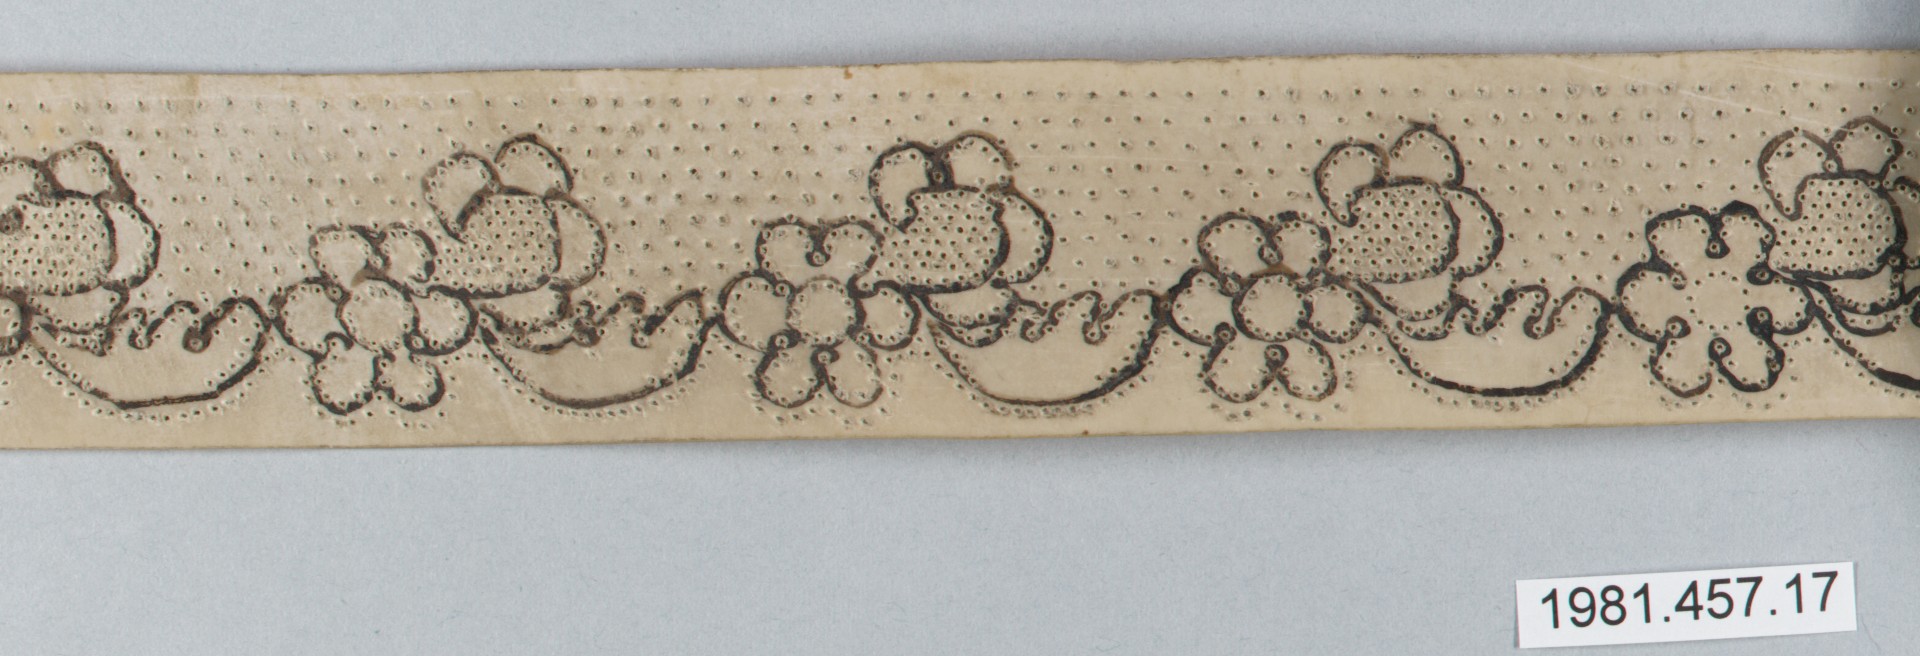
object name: pattern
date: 1840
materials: parchment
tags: flowers